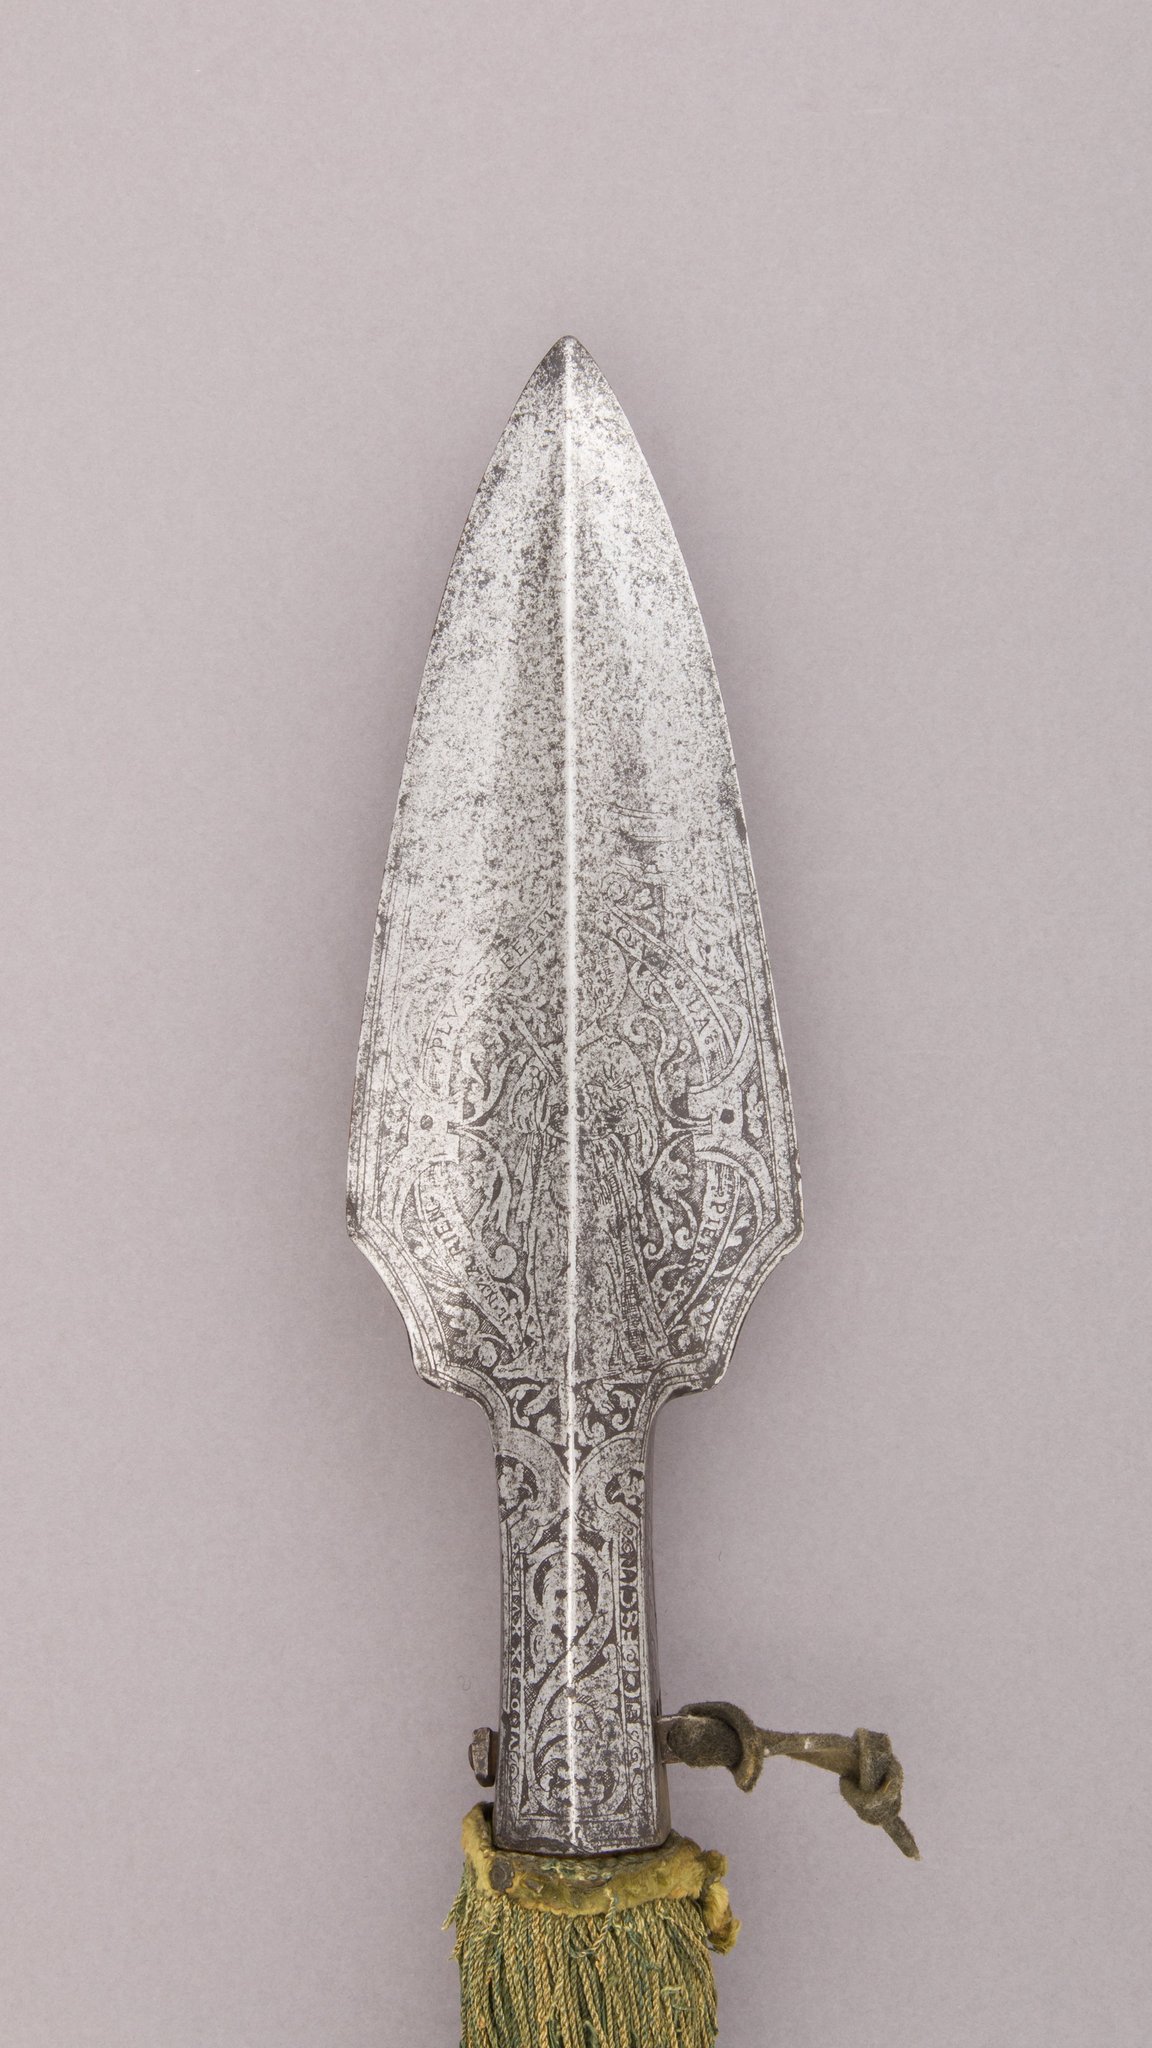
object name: boar spear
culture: french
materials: leather, steel, textile, wood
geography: france